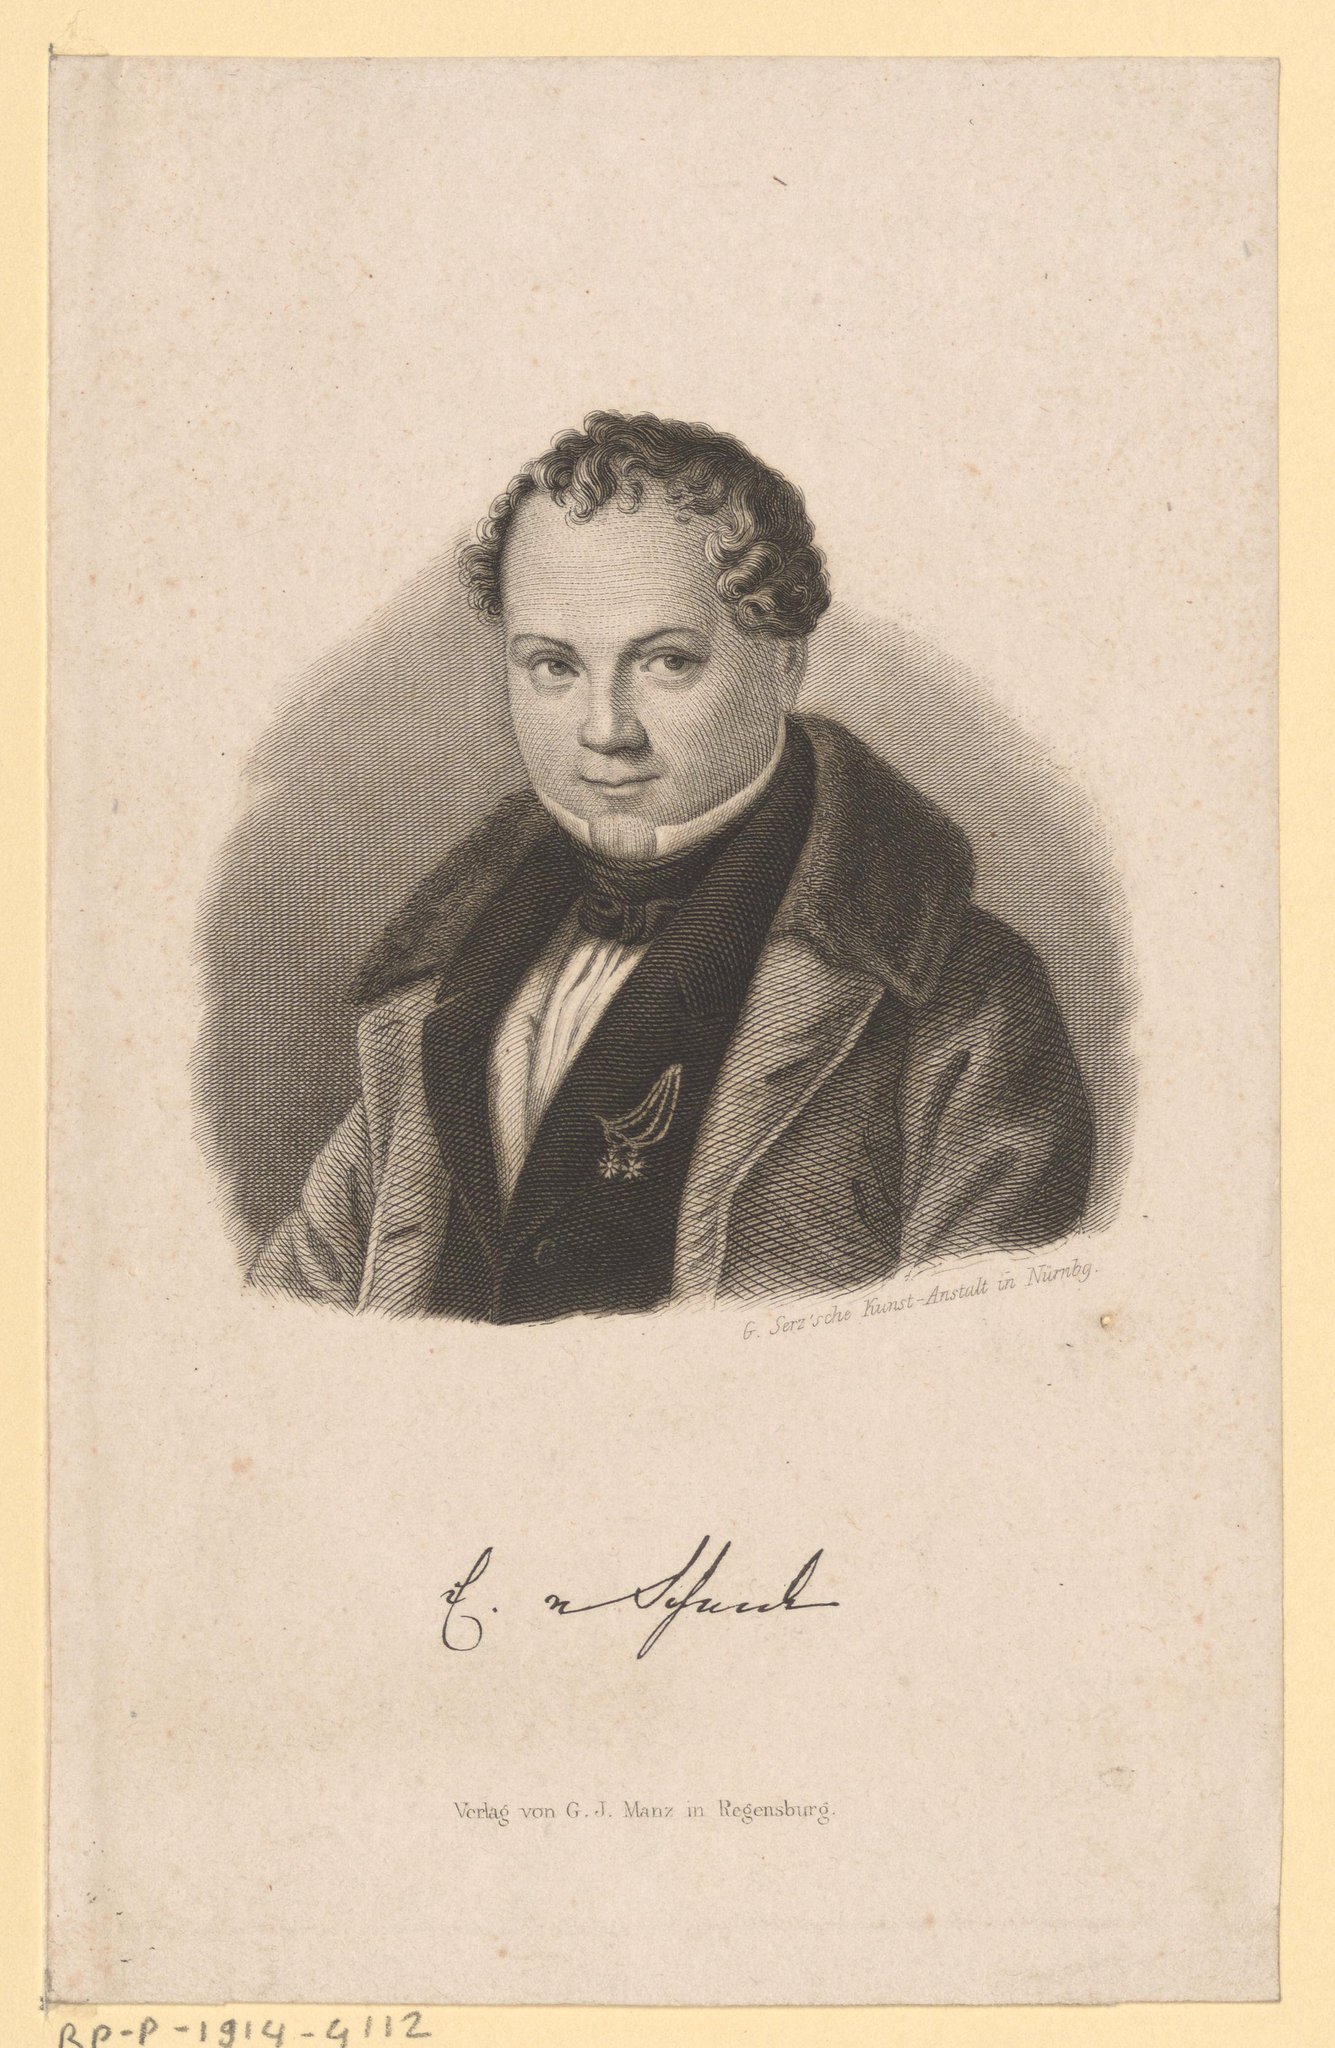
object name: print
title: Portret van Eduard von Schenk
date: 1835-1848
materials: paper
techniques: engraving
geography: regensburg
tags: historical persons, writer, poet, author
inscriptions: collector's mark: Lugt 2228